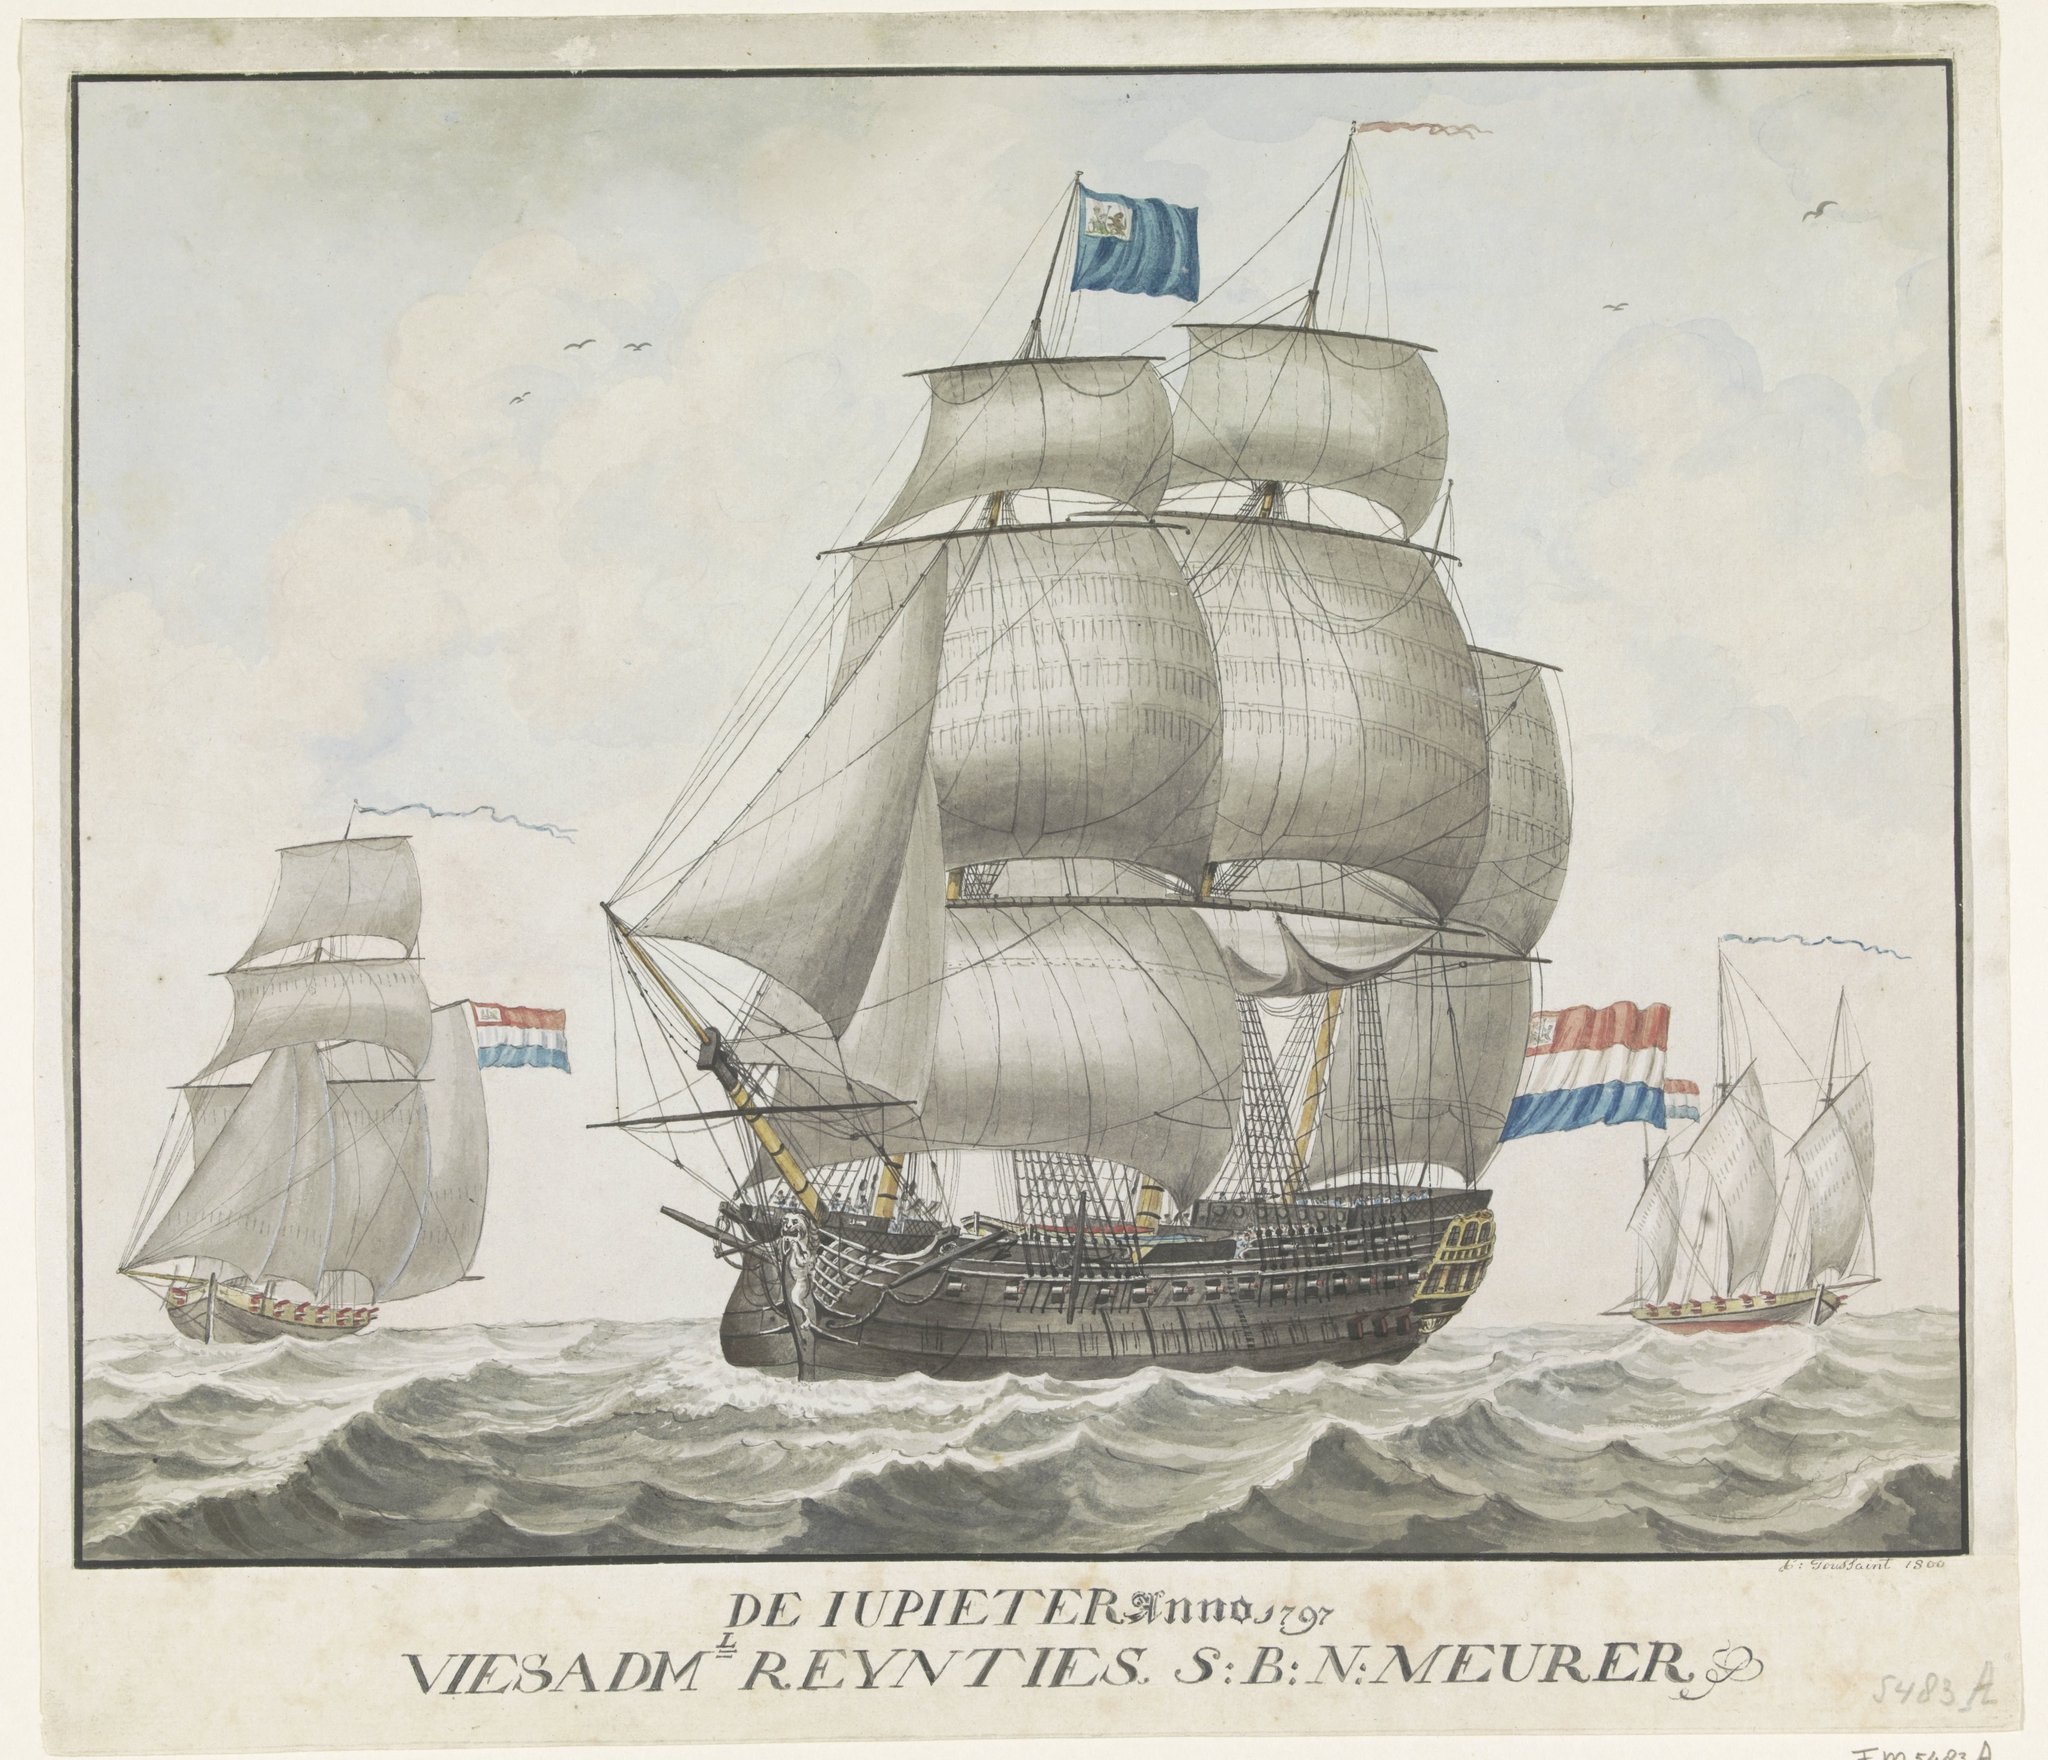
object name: drawing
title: Oorlogsschip De Jupiter, 1797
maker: c. toussaint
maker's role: draughtsman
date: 1800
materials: paper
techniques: brush, pen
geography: netherlands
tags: ships (in general) (+ propulsion of vehicle, ship, etc. by wind), navy (+ sailing-ships), battle of camperdown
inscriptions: collector's mark: Lugt 2228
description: Het Bataafse oorlogsschip de Jupiter, onder vice-admiraal Hermanus Reijntjes en schout-bij-nacht Frederik Alexander Meurer. Het schip maakte deel uit van de Bataafse vloot die werd verslagen door de Britten tijdens de zeeslag bij Kamperduin op 11 oktober 1797. Op volle zee zeilend naar links, begeleid door twee kleinere gewapende schepen.